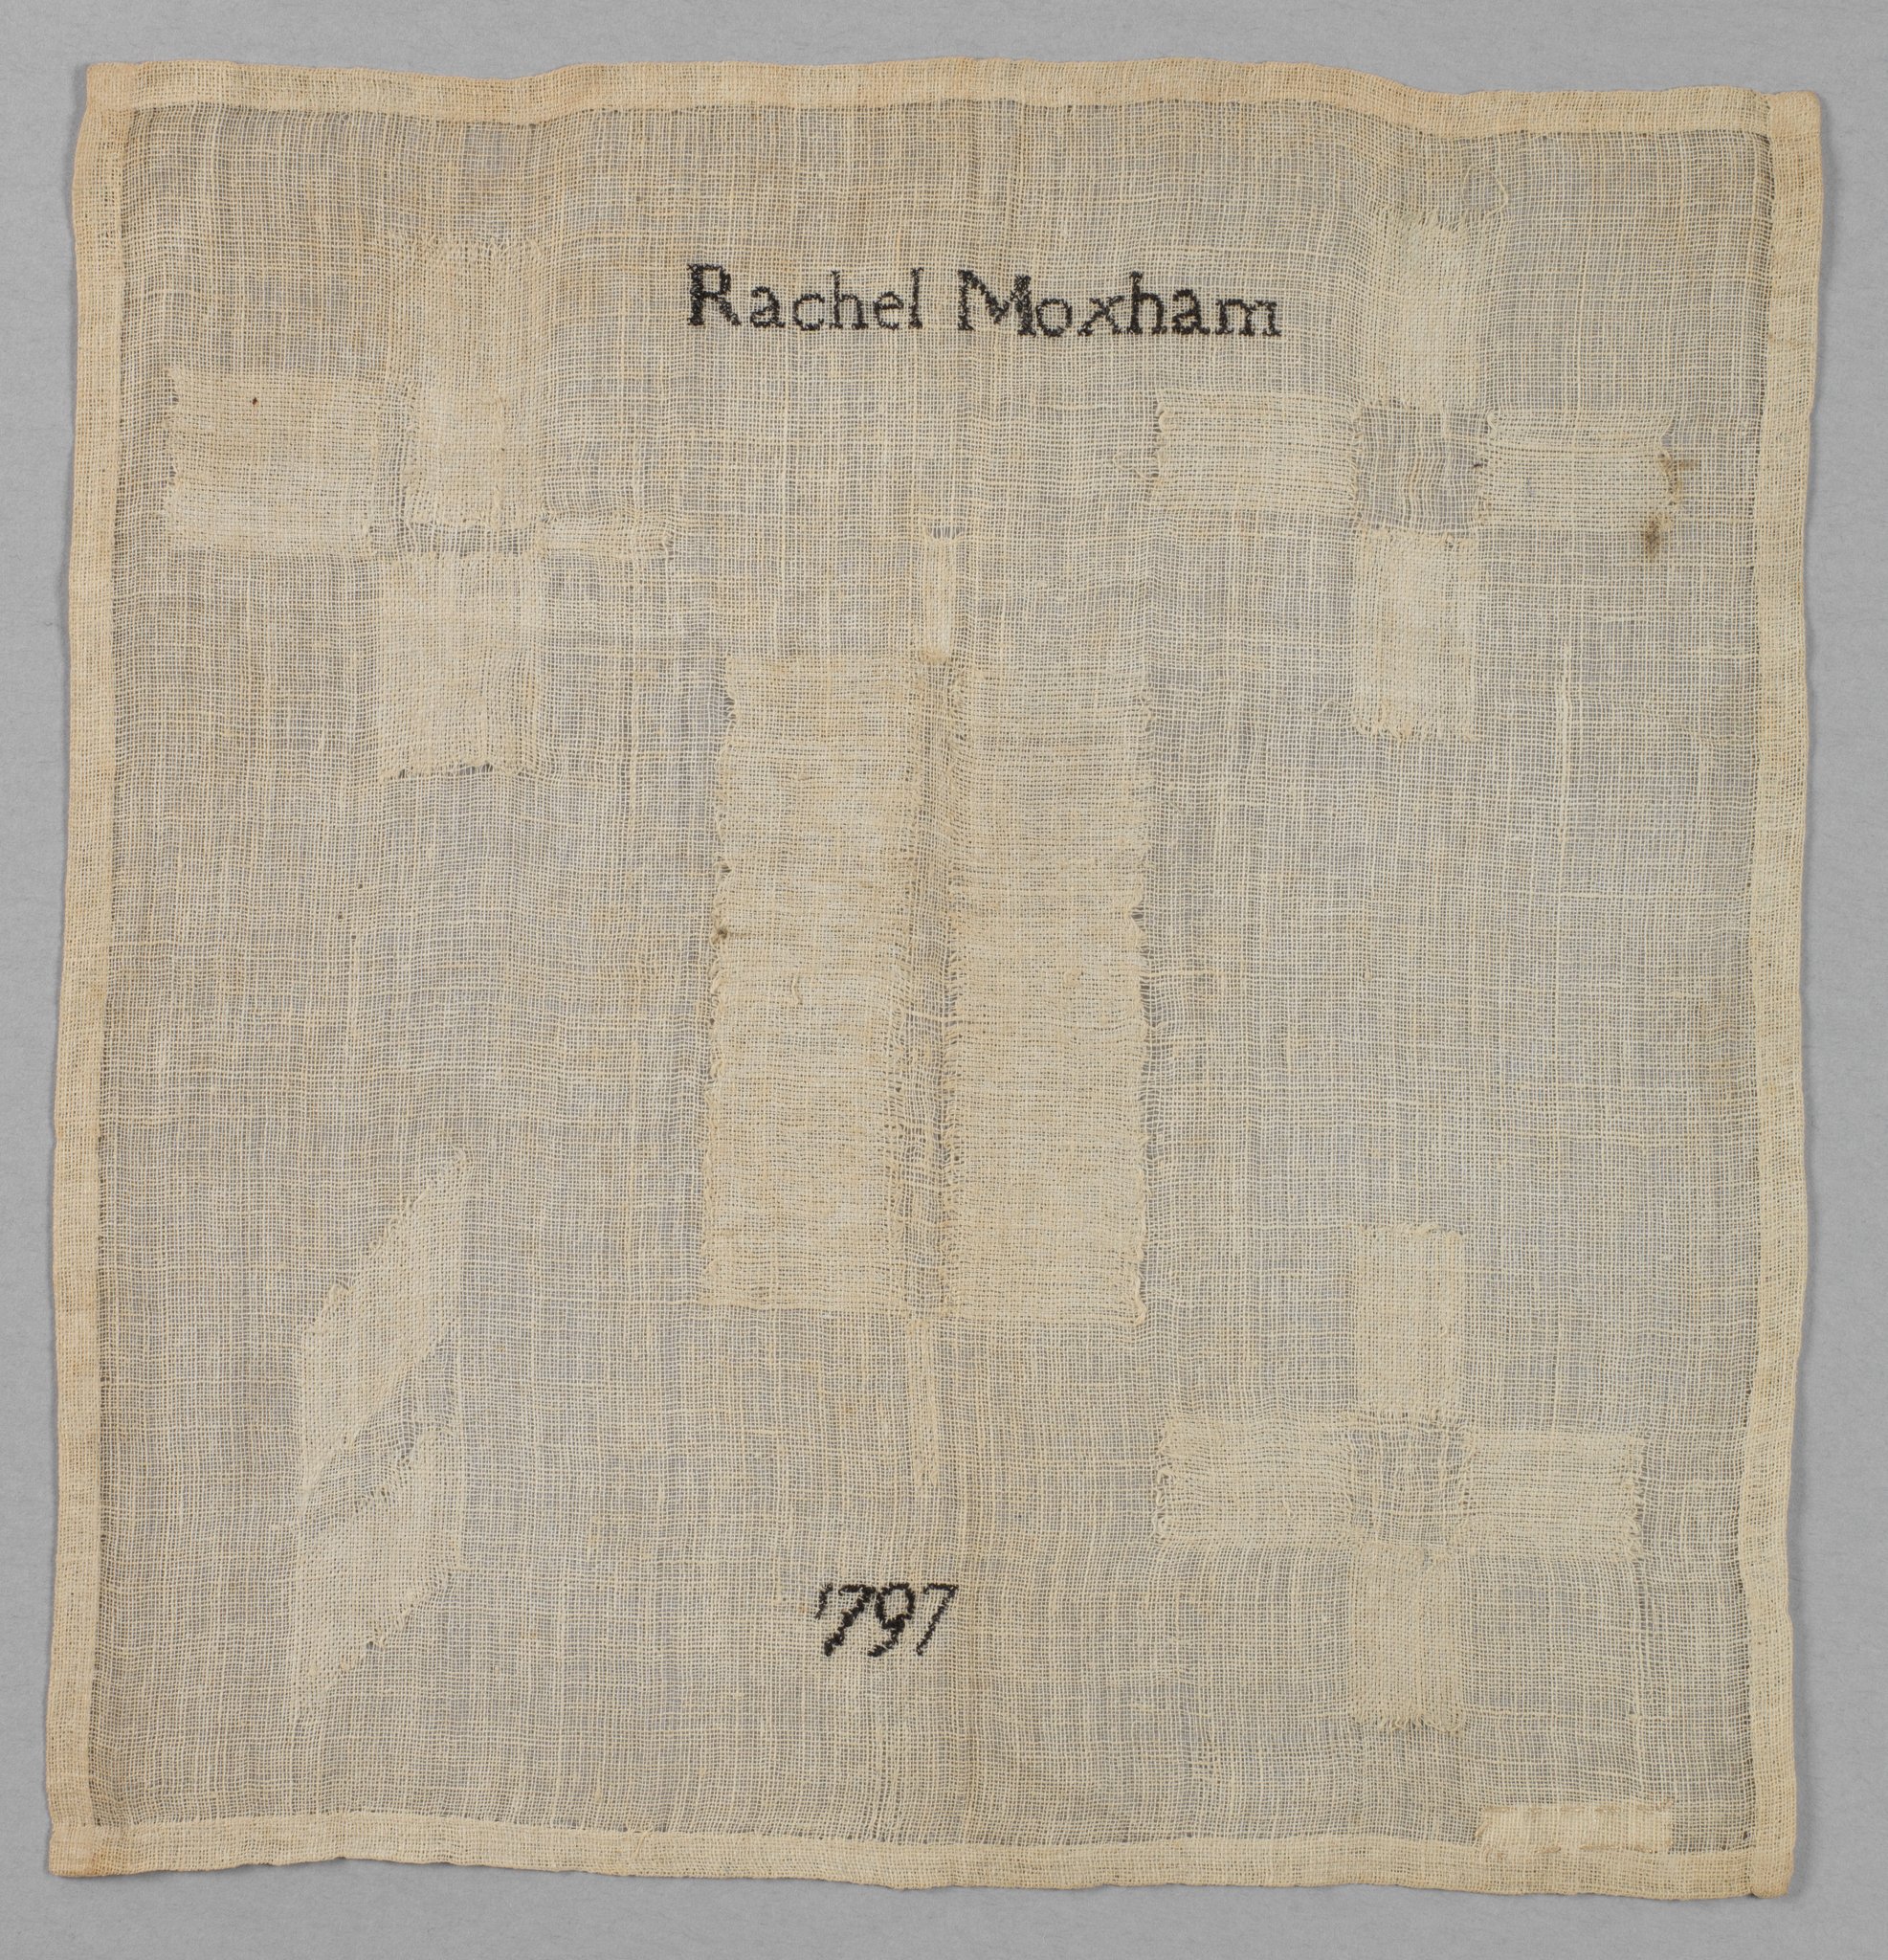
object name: sampler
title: Embroidered darning sampler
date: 1797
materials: cotton, textile